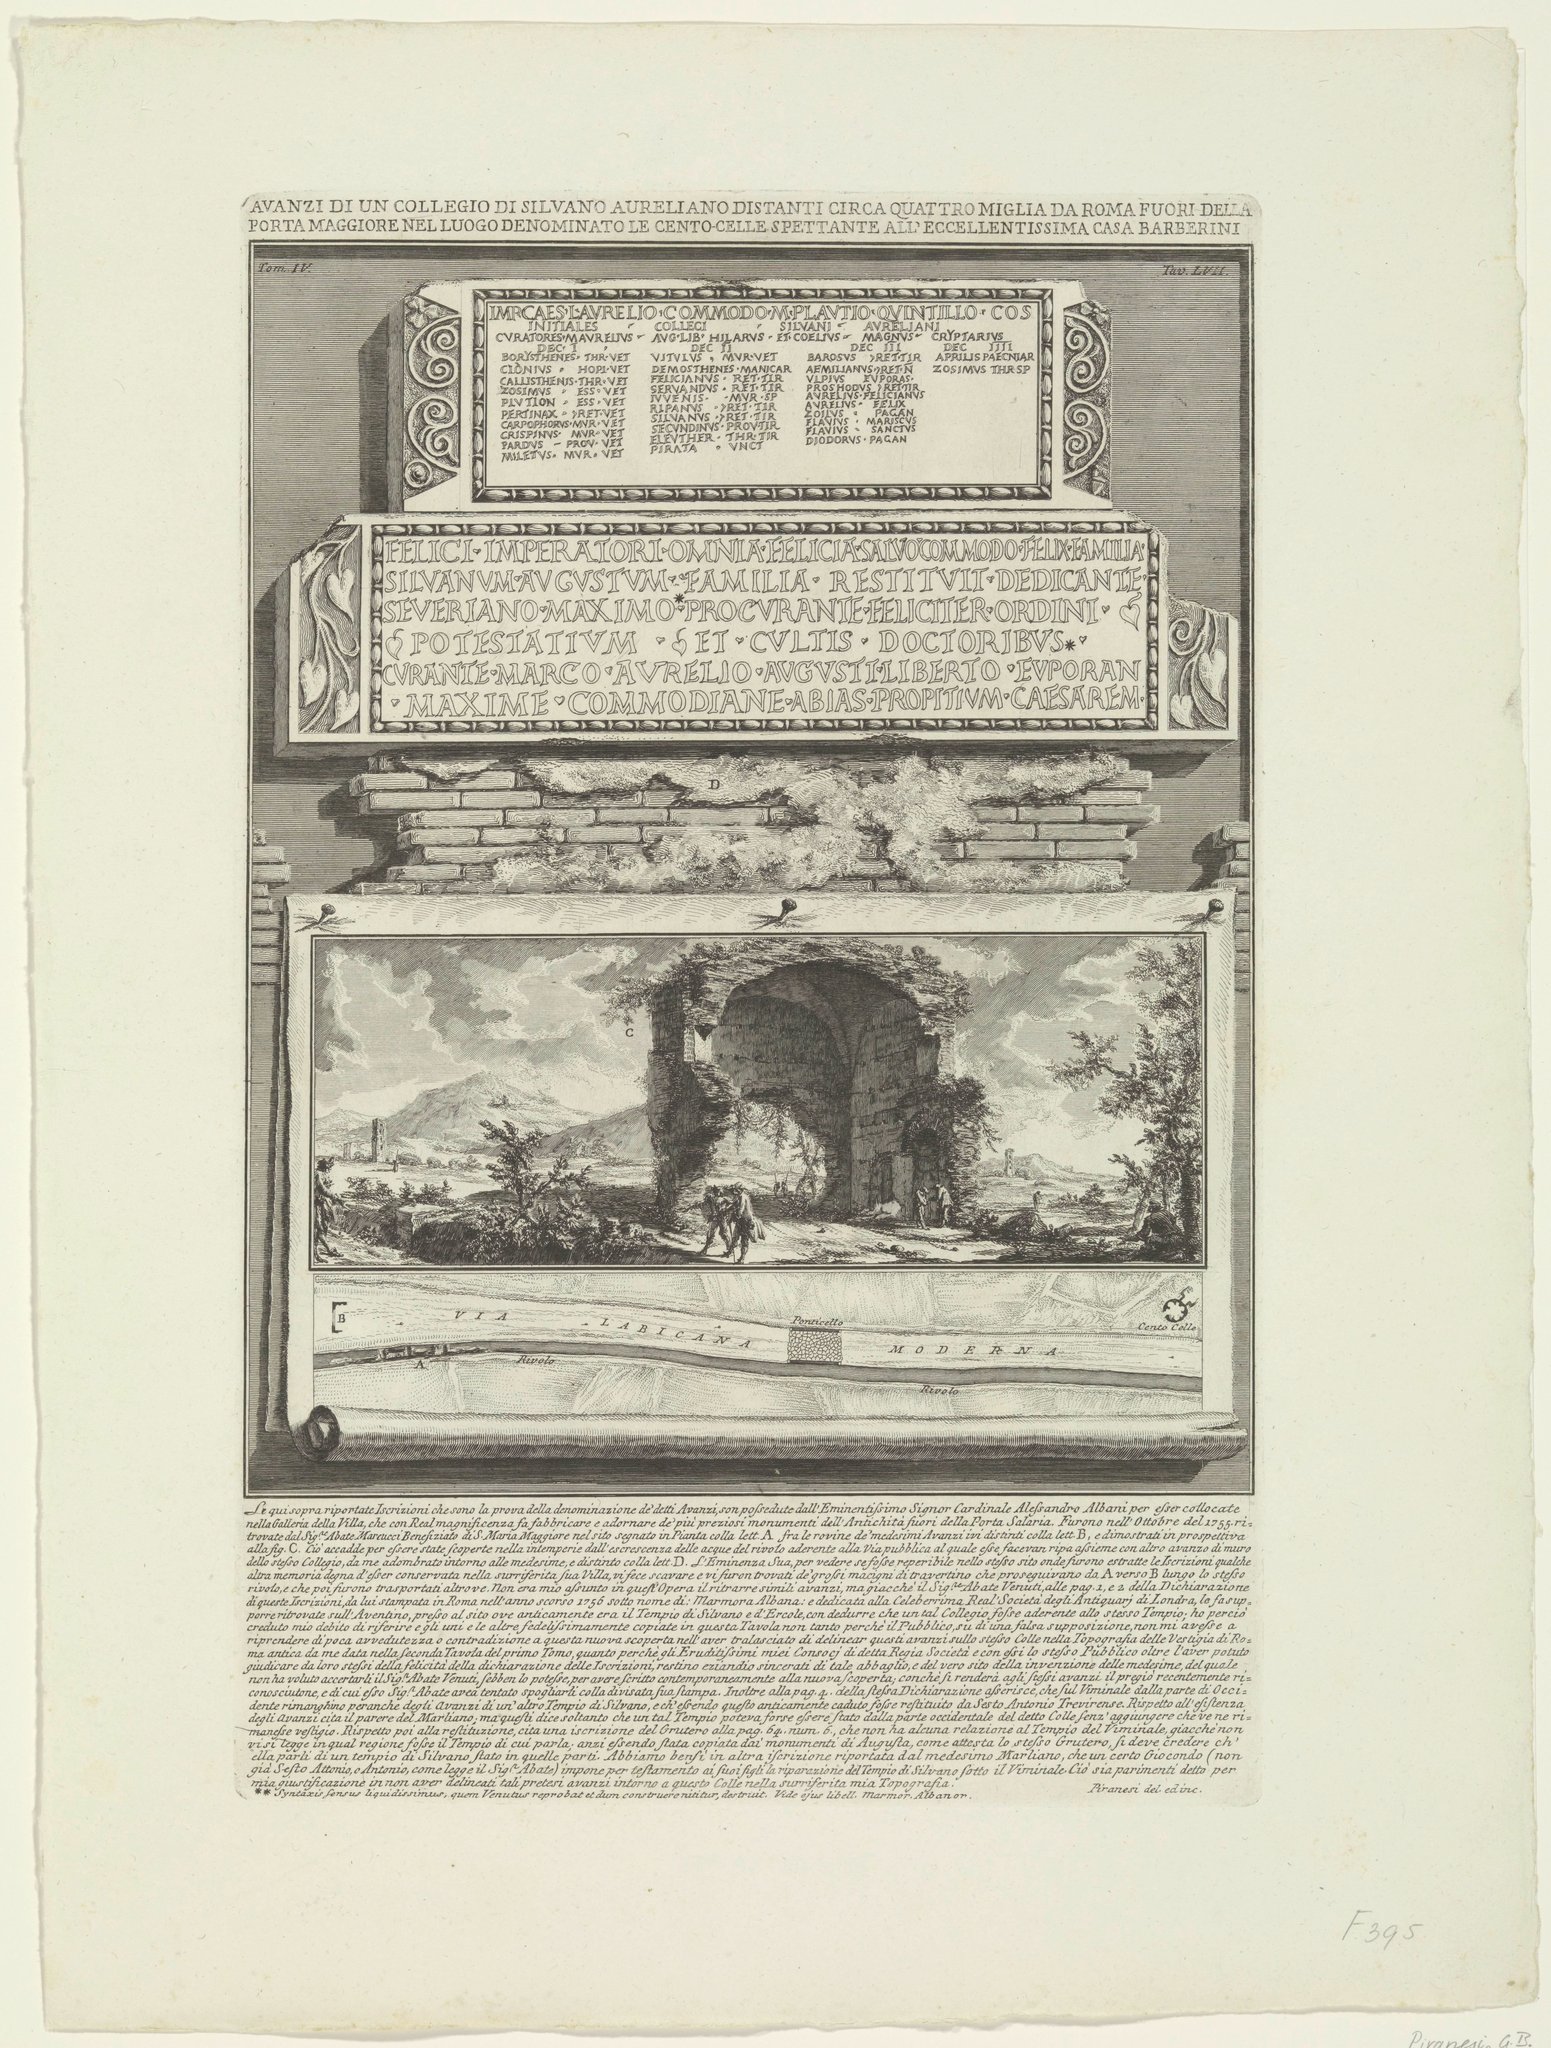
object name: print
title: Archeologische vondsten in en rond Rome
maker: giovanni battista piranesi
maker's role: designer, draughtsman, print maker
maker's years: 1720-1778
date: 1756-1757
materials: paper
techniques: etching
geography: rome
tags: ruin of a building ~ architecture, landscape with ruins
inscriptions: collector's mark: Lugt 2228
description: Aan een muur vastgespijkerd papieren blad met een gezicht op een ruïne, volgens de titel de restanten van een Collegio van Silvanus Aurelianus. Onder de afbeelding een plattegrond van de Via Labicana met de ruïne links. Boven twee details van inscripties. In de ondermarge 23 regels tekst in het Italiaans, onder meer een verklarende lijst met letters. Genummerd linksboven: Tom. IV. Genummerd rechtsboven: Tav. LVII.